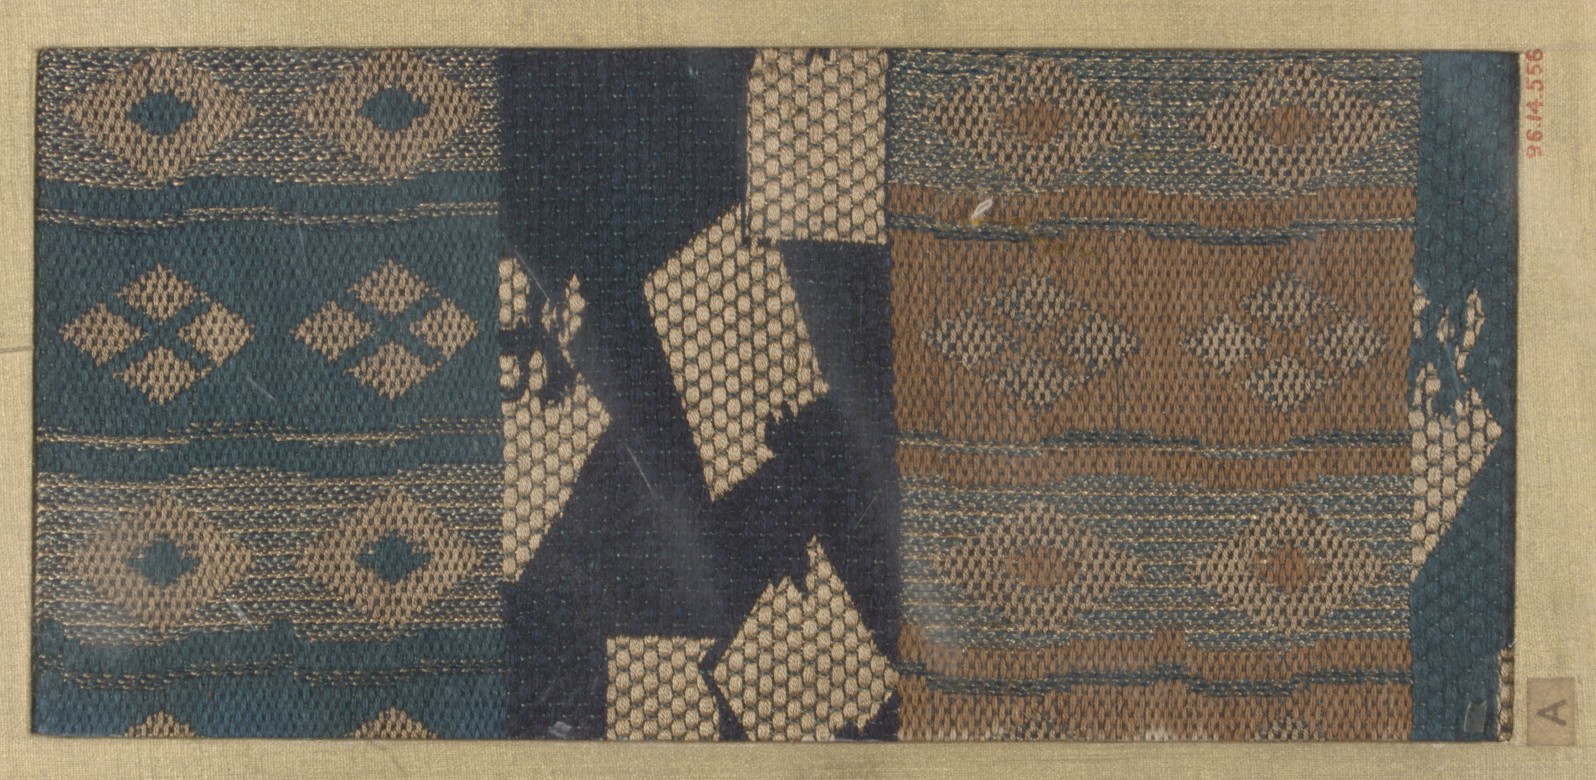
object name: piece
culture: japanese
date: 1701-1900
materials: silk